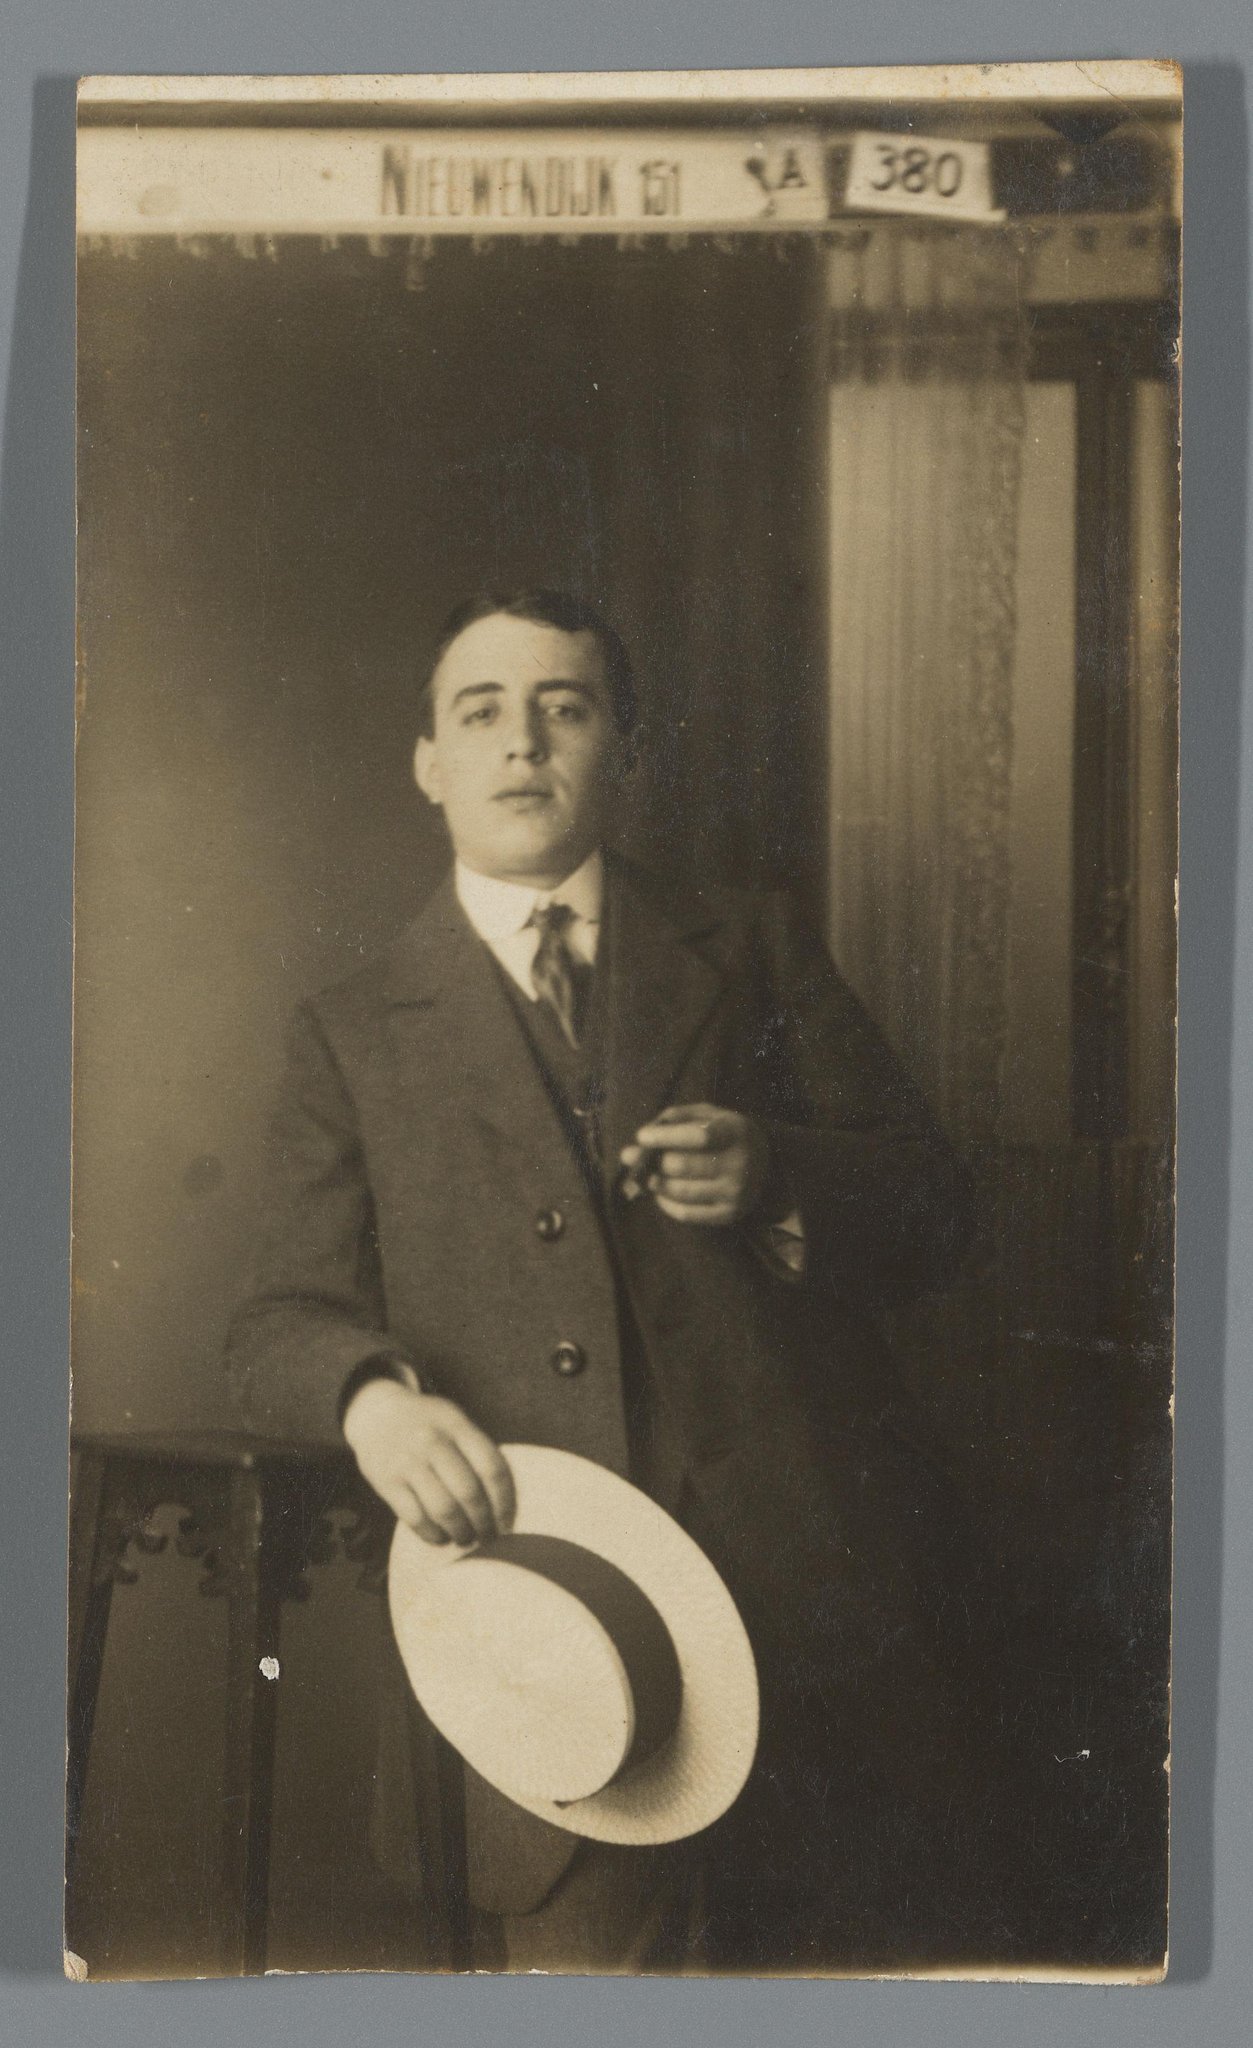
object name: snapshot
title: Portret van een onbekende man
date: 1912-1925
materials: photographic support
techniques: gelatin silver print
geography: amsterdam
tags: amsterdam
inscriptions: inscription: ‘Nieuwendijk 151 Nr. A380’